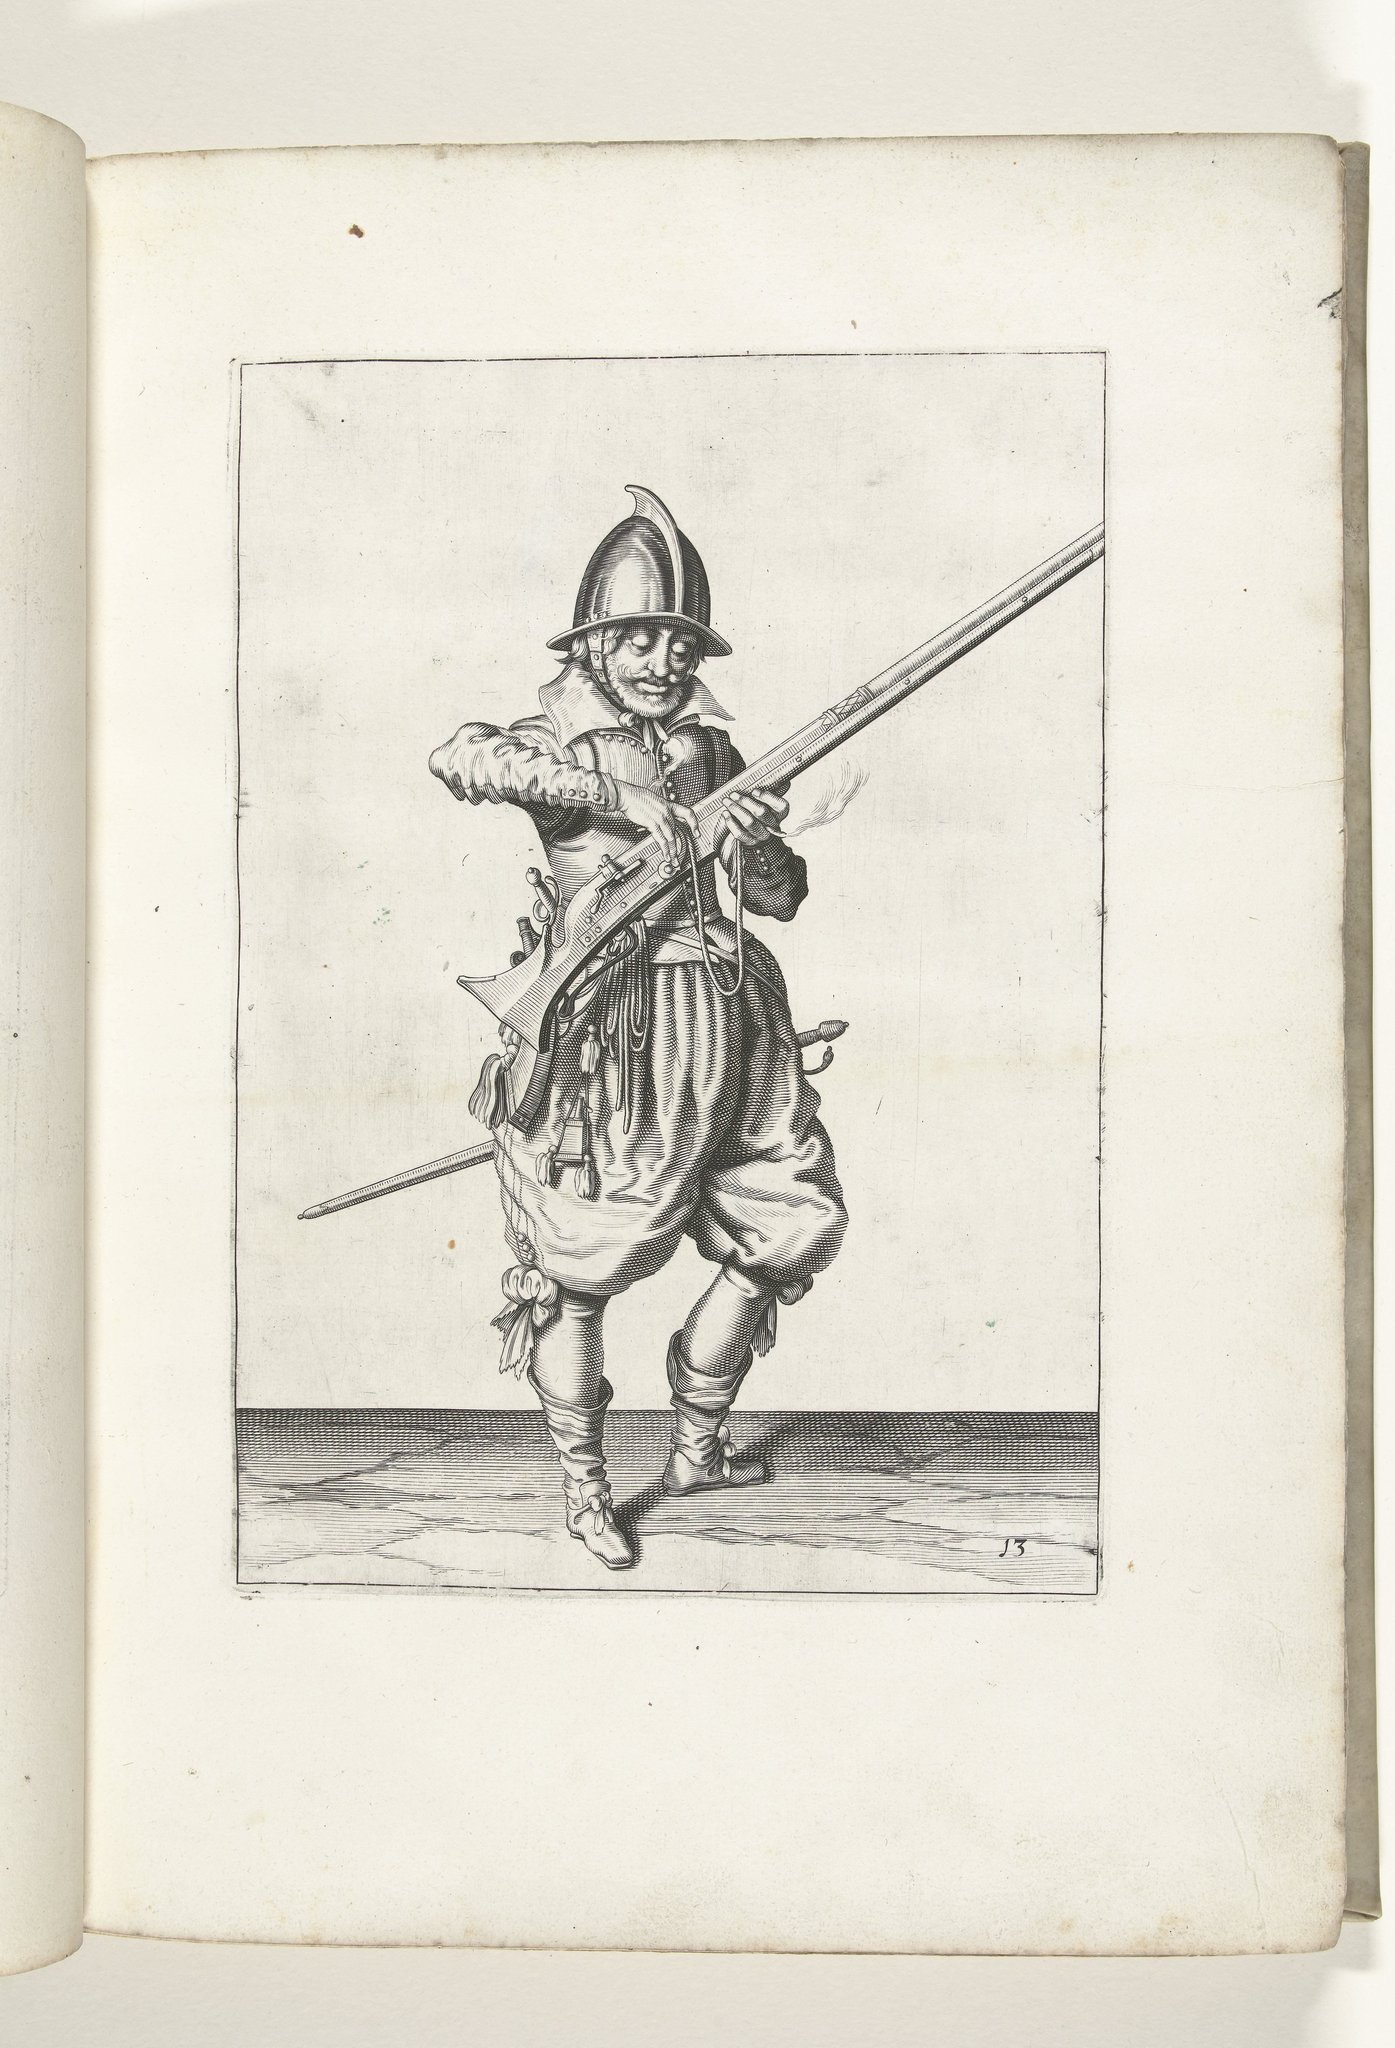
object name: print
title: Soldaat die zijn lont van de haan van zijn roer losmaakt (nr. 13), ca. 1600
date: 1597-1607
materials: paper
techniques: engraving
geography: northern netherlands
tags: the hague, maurice (prince of orange), handling of weapons ~ military training, weapons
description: Een soldaat, ten voeten uit, naar rechts, die een roer (een bepaald type vuurwapen) met zijn linkerhand vasthoudt (nr. 13), ca. 1600. Met zijn rechterhand maakt hij de brandende lont los die op de haan (onderdeel van het ontstekingsmechanisme) van zijn roer ligt. Plaat 13 in de instructies voor het hanteren van de roer: Corte onderwysinghe op de figuerliicke afbeeldinghe, belanghende t'rechte ghebruyck des Roers. Onderdeel van de illustraties in: J. de Gheyn, Wapenhandelinghe van Roers Musquetten ende spiessen, 's-Gravenhage, 1607. Krijgswezen rond 1600.